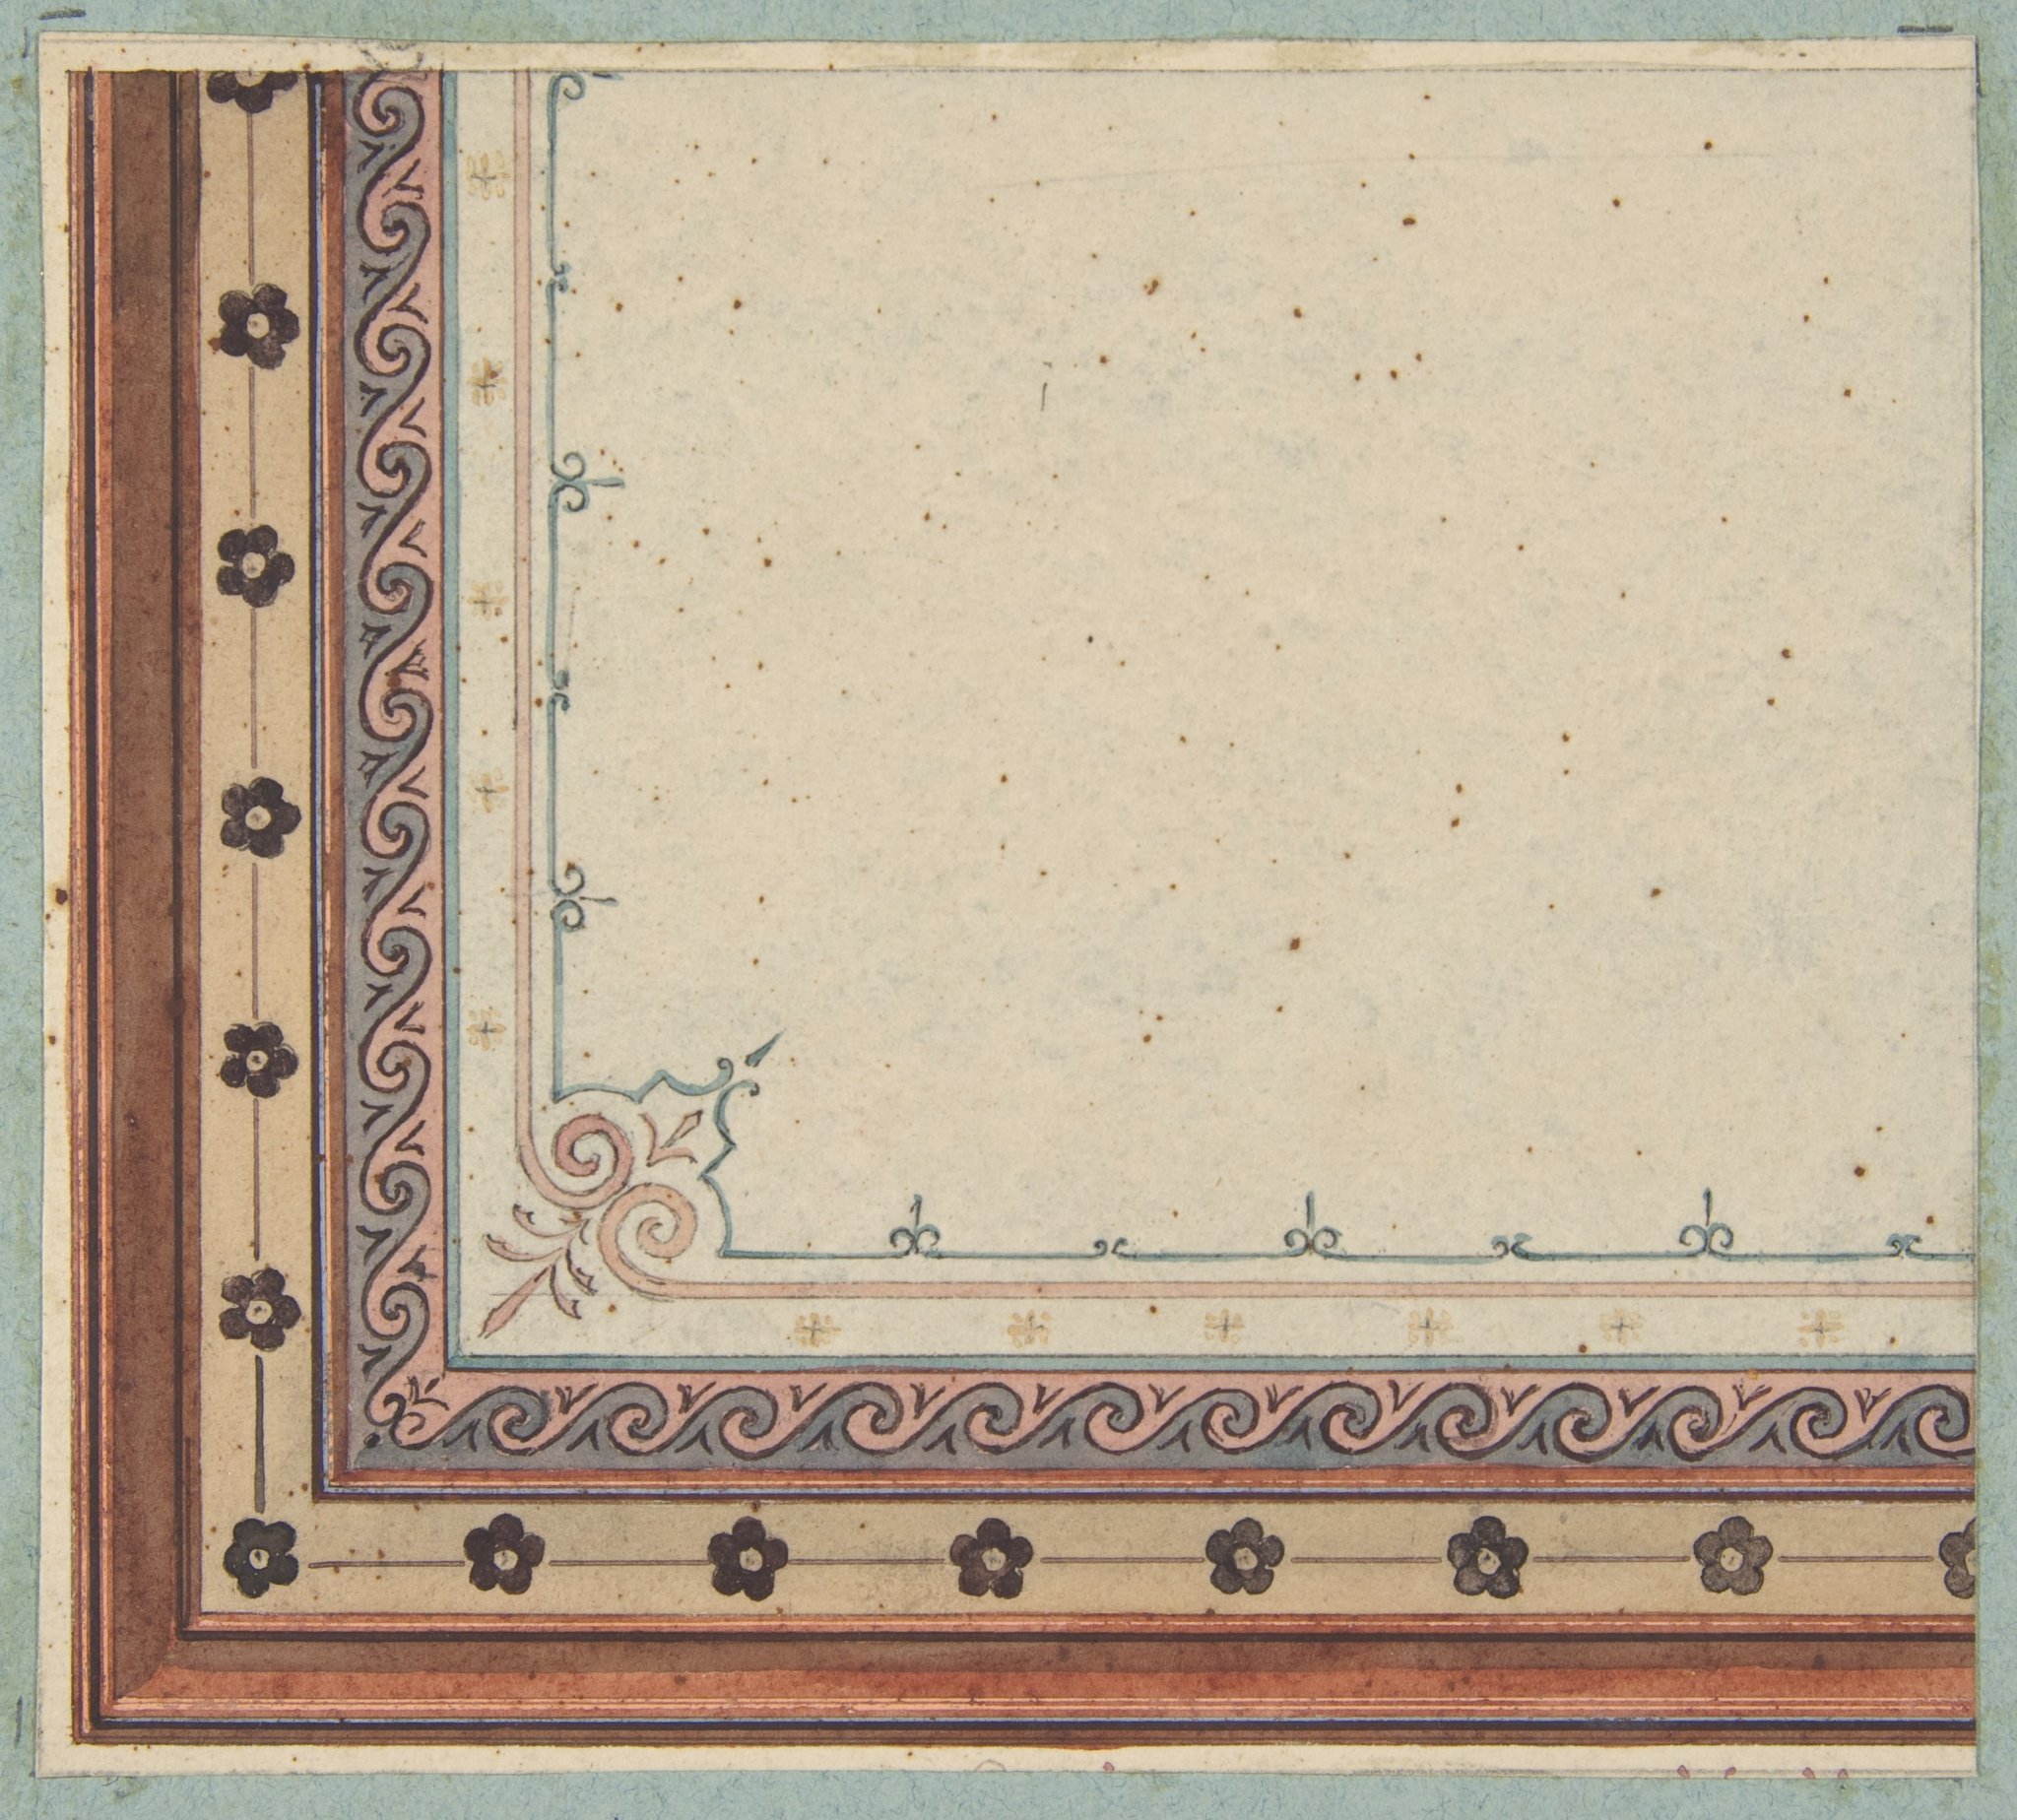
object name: drawing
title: Design for the decoration of a ceiling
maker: jules-edmond-charles lachaise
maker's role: artist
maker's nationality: french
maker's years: 1897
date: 1851-1900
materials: ink, watercolor, paper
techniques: pen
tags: ceilings